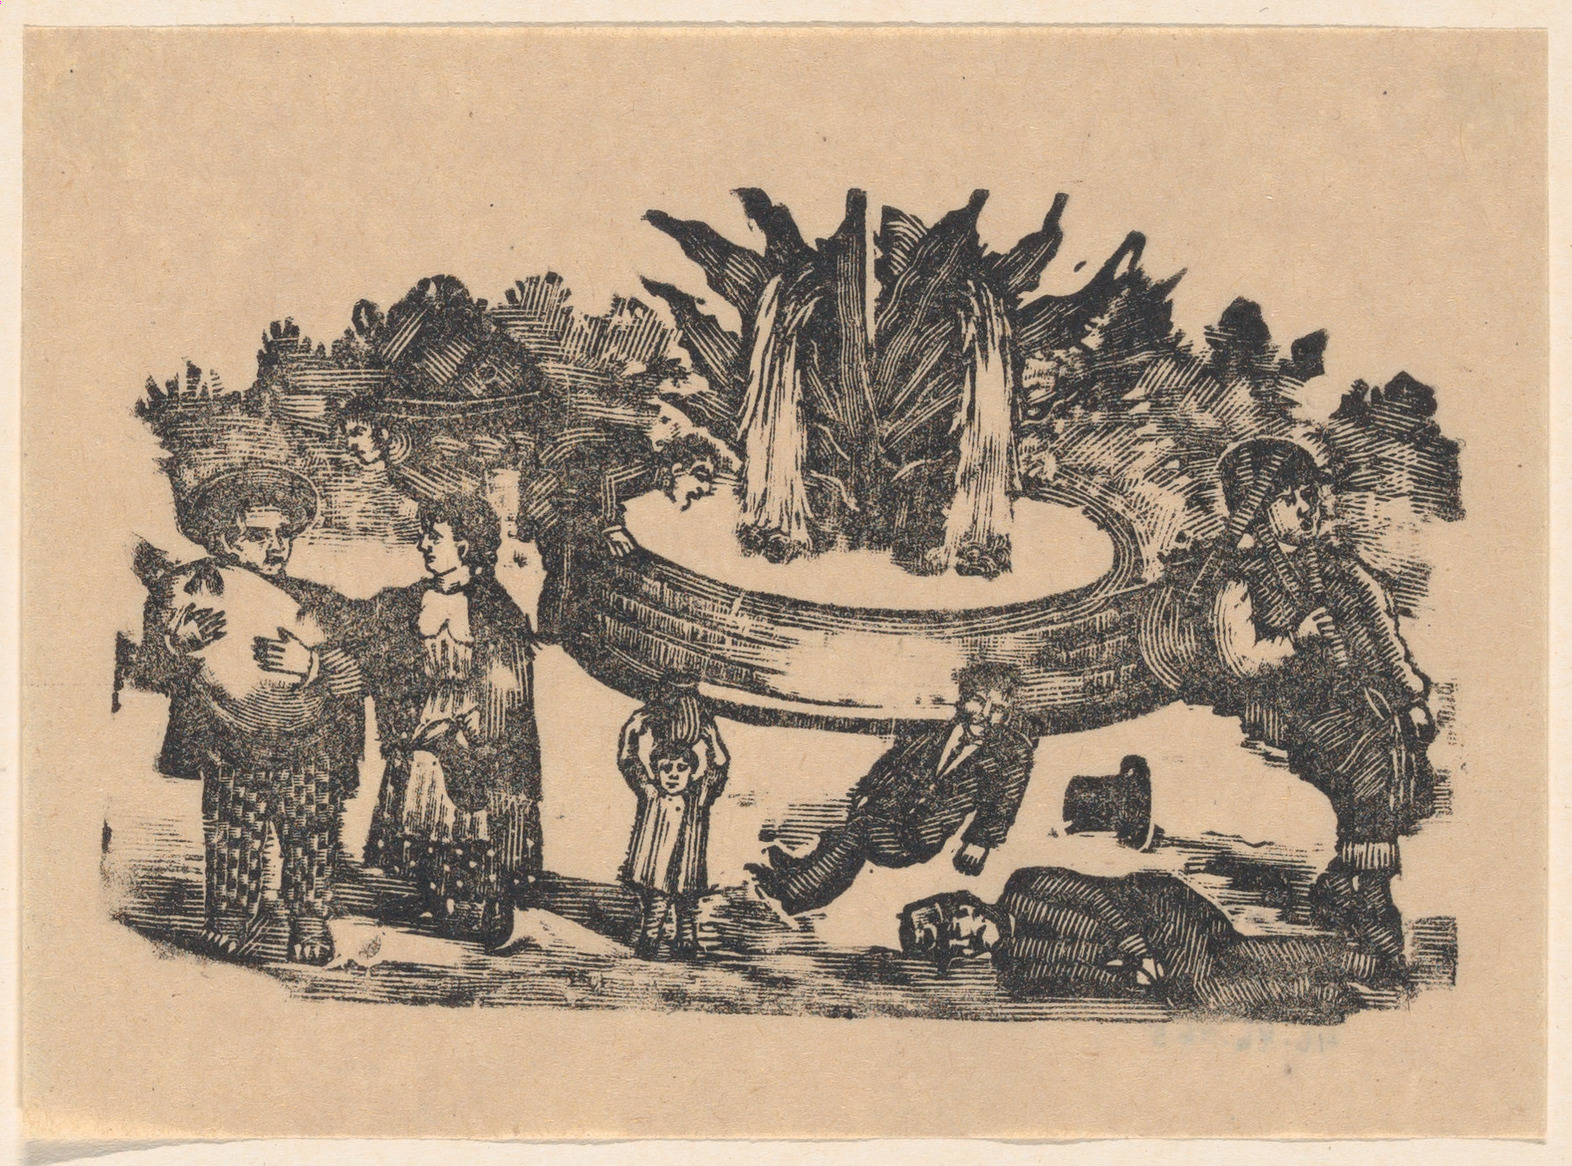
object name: print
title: Miraculous fountain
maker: josé guadalupe posada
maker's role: artist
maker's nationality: mexican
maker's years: 1852-1913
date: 1890-1910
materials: metal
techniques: engraving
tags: fountains,boys,men,women